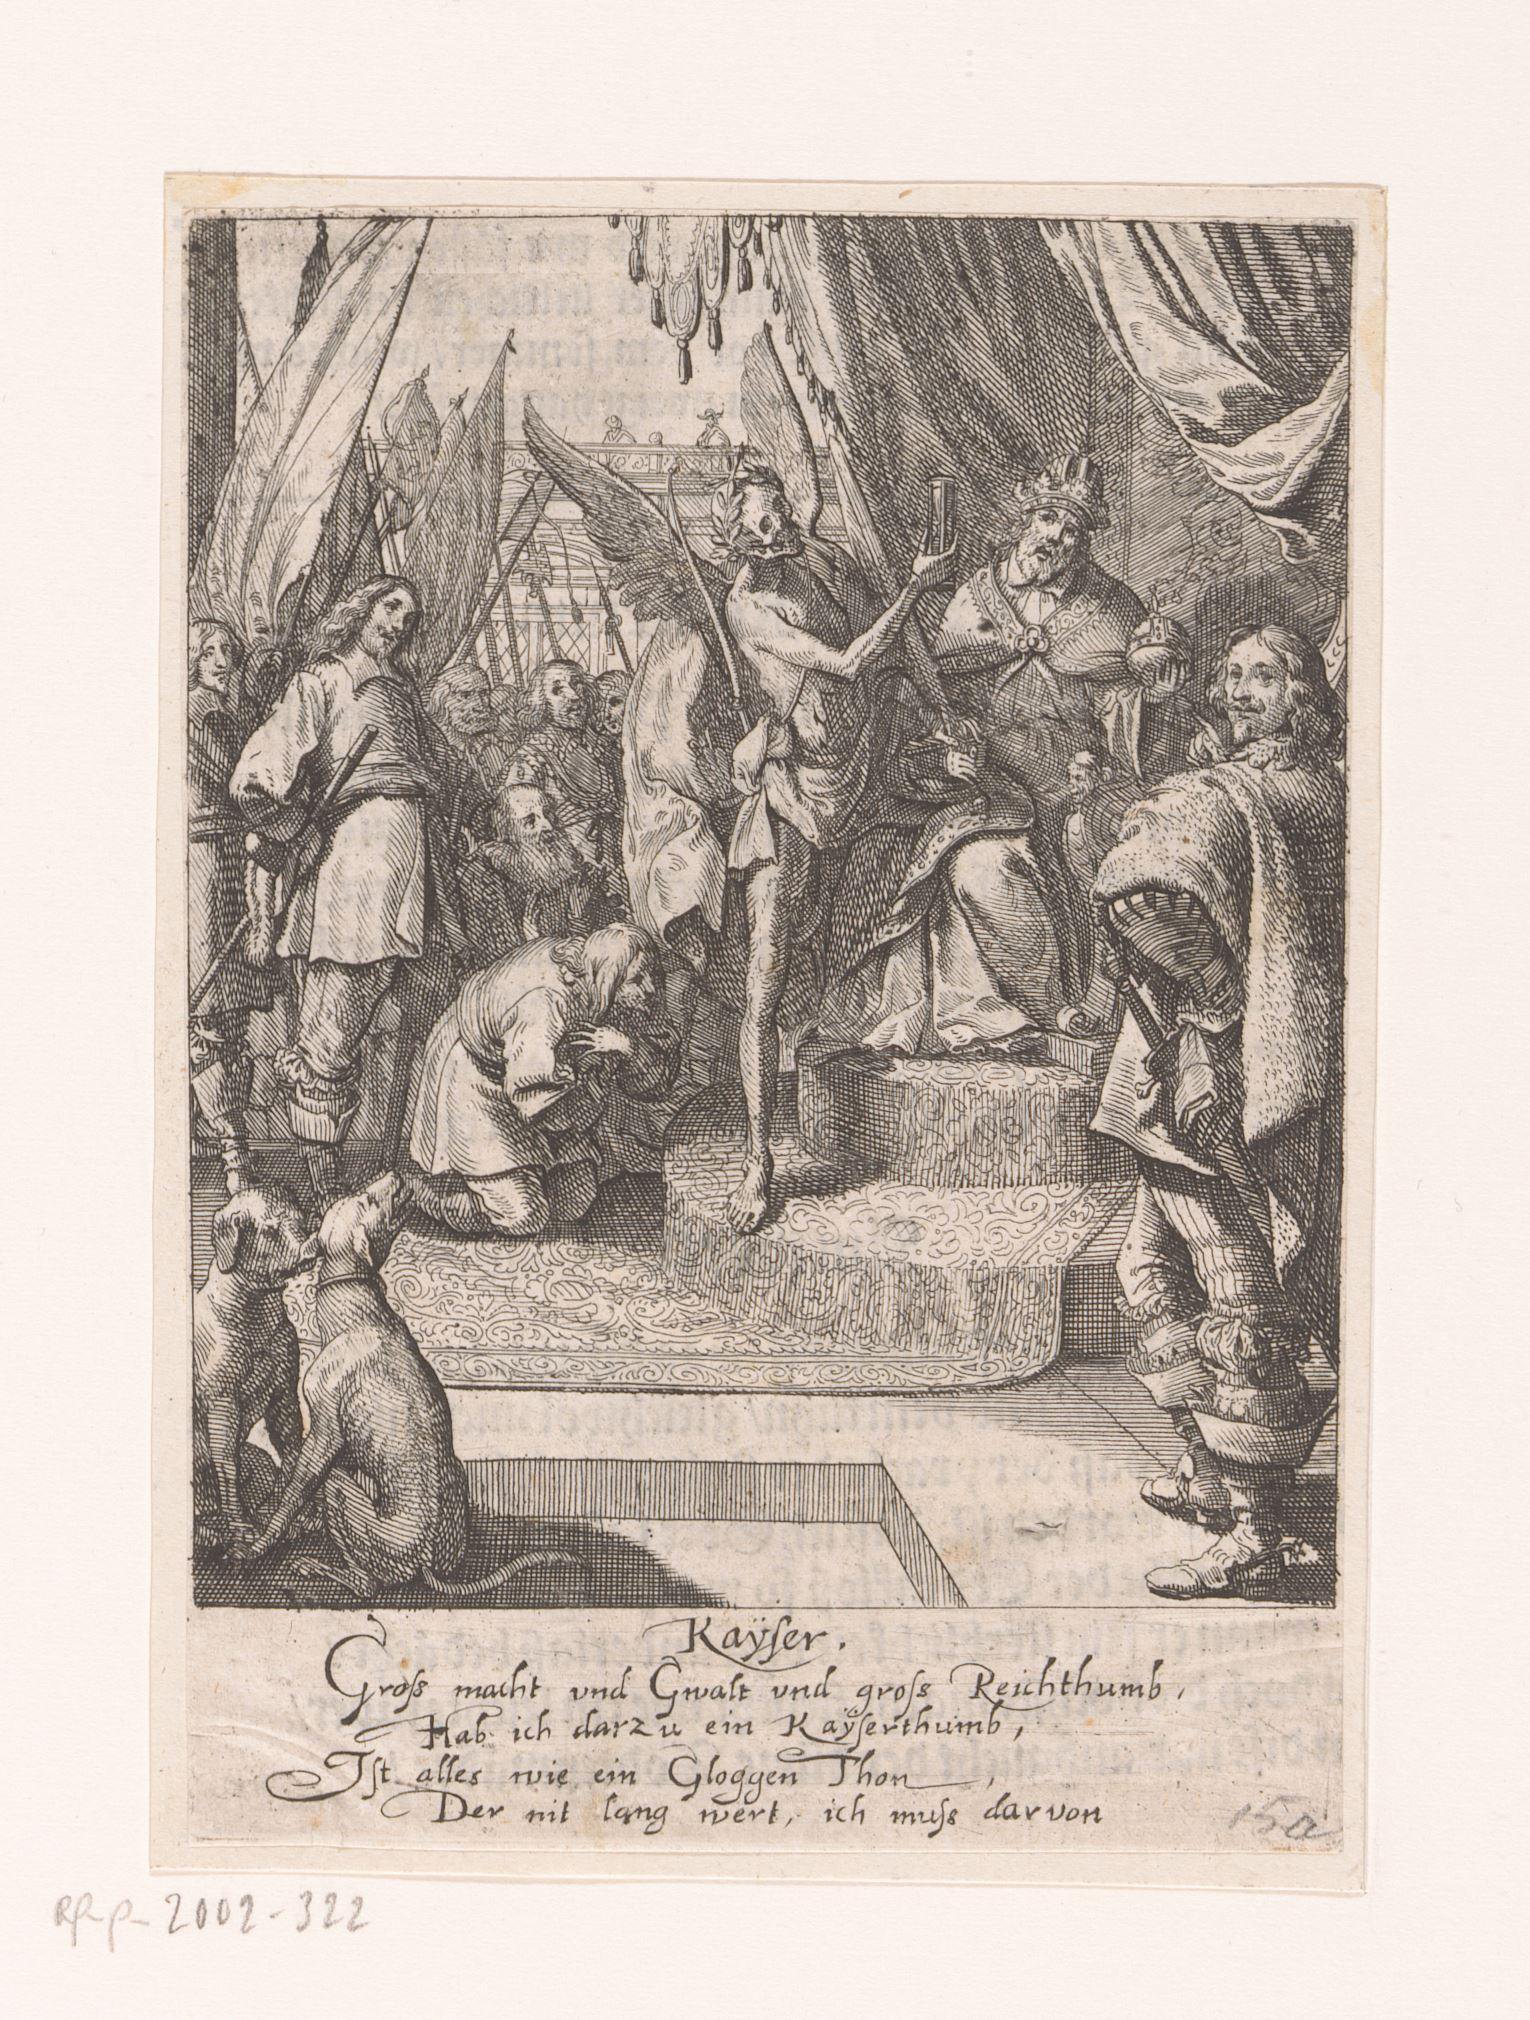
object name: book illustration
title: Kayser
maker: johann jakob bodmer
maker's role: printer, publisher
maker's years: 1629-1650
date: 1650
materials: paper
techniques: etching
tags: personifications of death; 'morte' (ripa), dance of death; death together with one or more human beings, emperor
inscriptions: collector's mark: Lugt 2228, collector's mark: Lugt 2233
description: Prent uit: Meyer, Rudolph. Sterbenspiegel, das ist sonnenklare Vorstellung menschlicher Nichtigkeit durch alle Ständ und Geschlechter (...). Zürich: J.J. Bodmer, 1650.